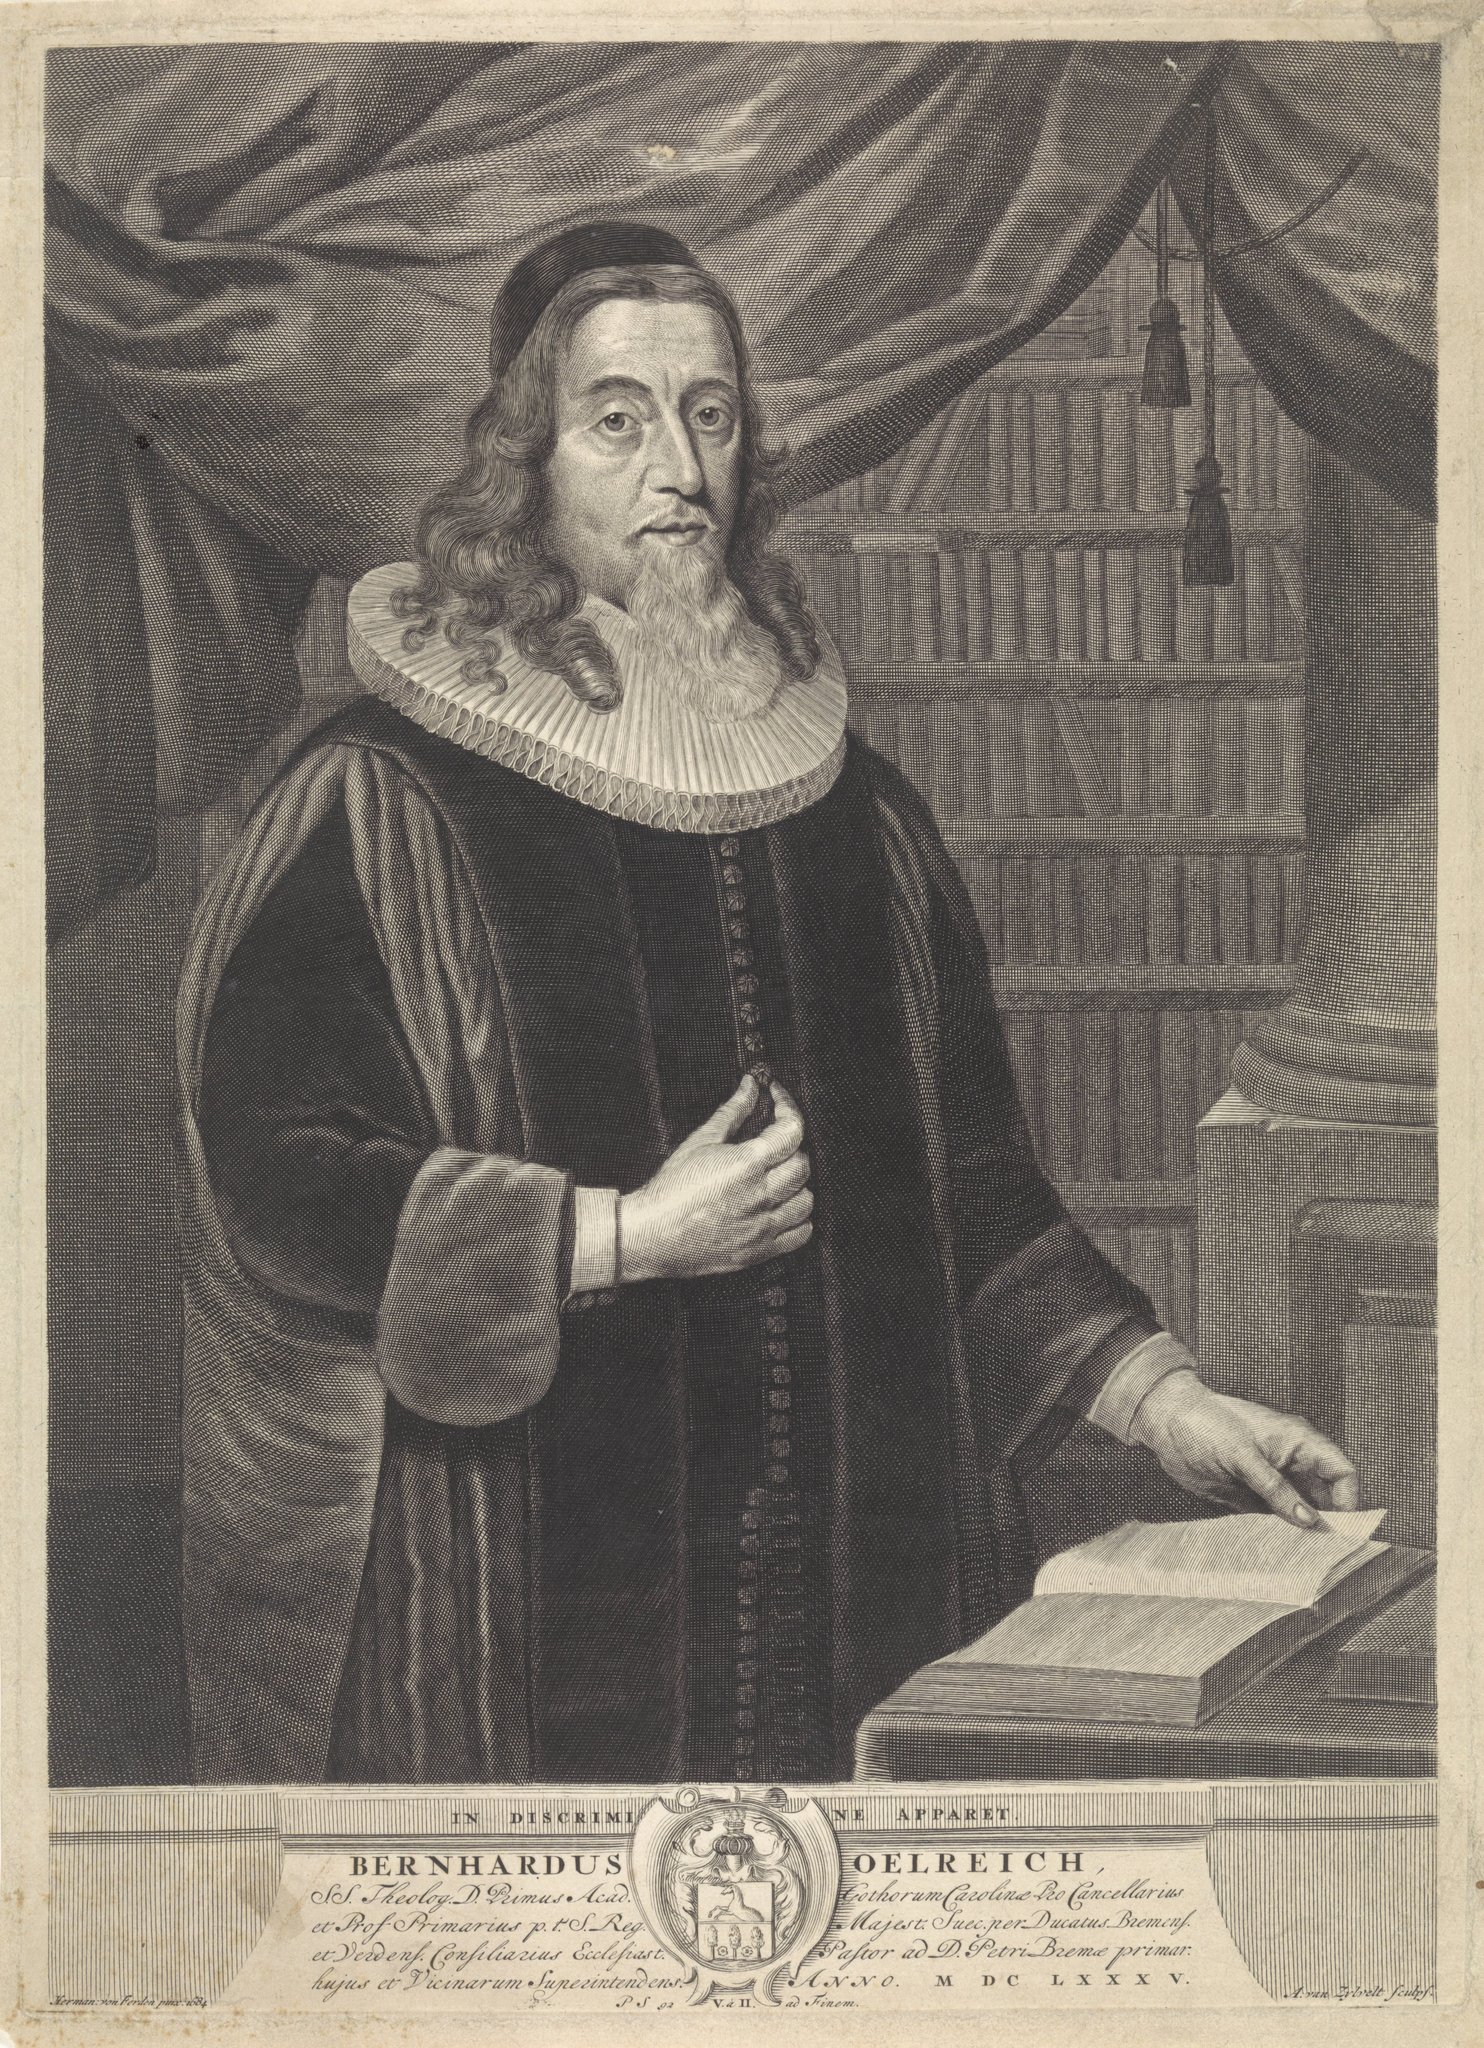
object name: print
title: Portret van Bernhard Oelreich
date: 1685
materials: paper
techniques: engraving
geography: amsterdam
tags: neck-gear ~ clothing (with name) (+ men's clothes), head-gear (with name)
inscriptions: collector's mark: Lugt 2233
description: De Duitse theoloog Bernhard Oelreich, staande bij een opengeslagen Bijbel. Onderaan in de marge zijn wapenschild en een vierregelige tekst in het Latijn.